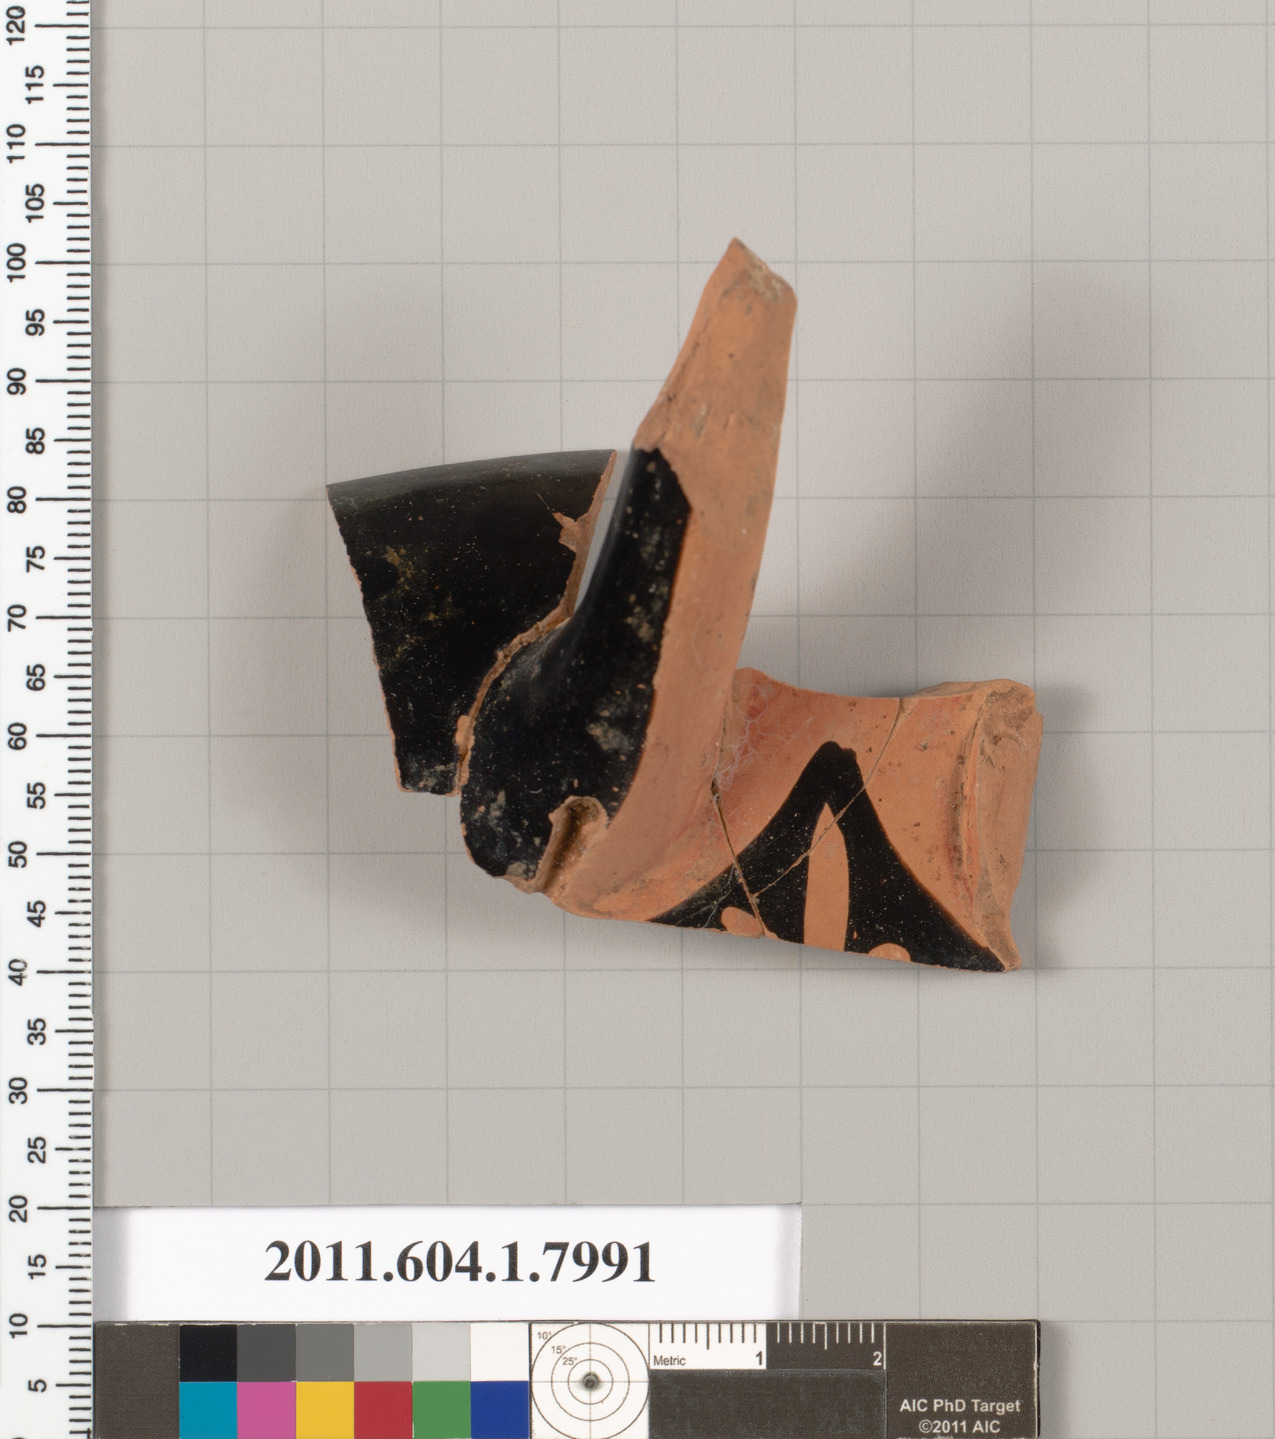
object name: kylix fragment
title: Terracotta fragment of a kylix (drinking cup)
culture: greek, attic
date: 460-450 BCE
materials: terracotta